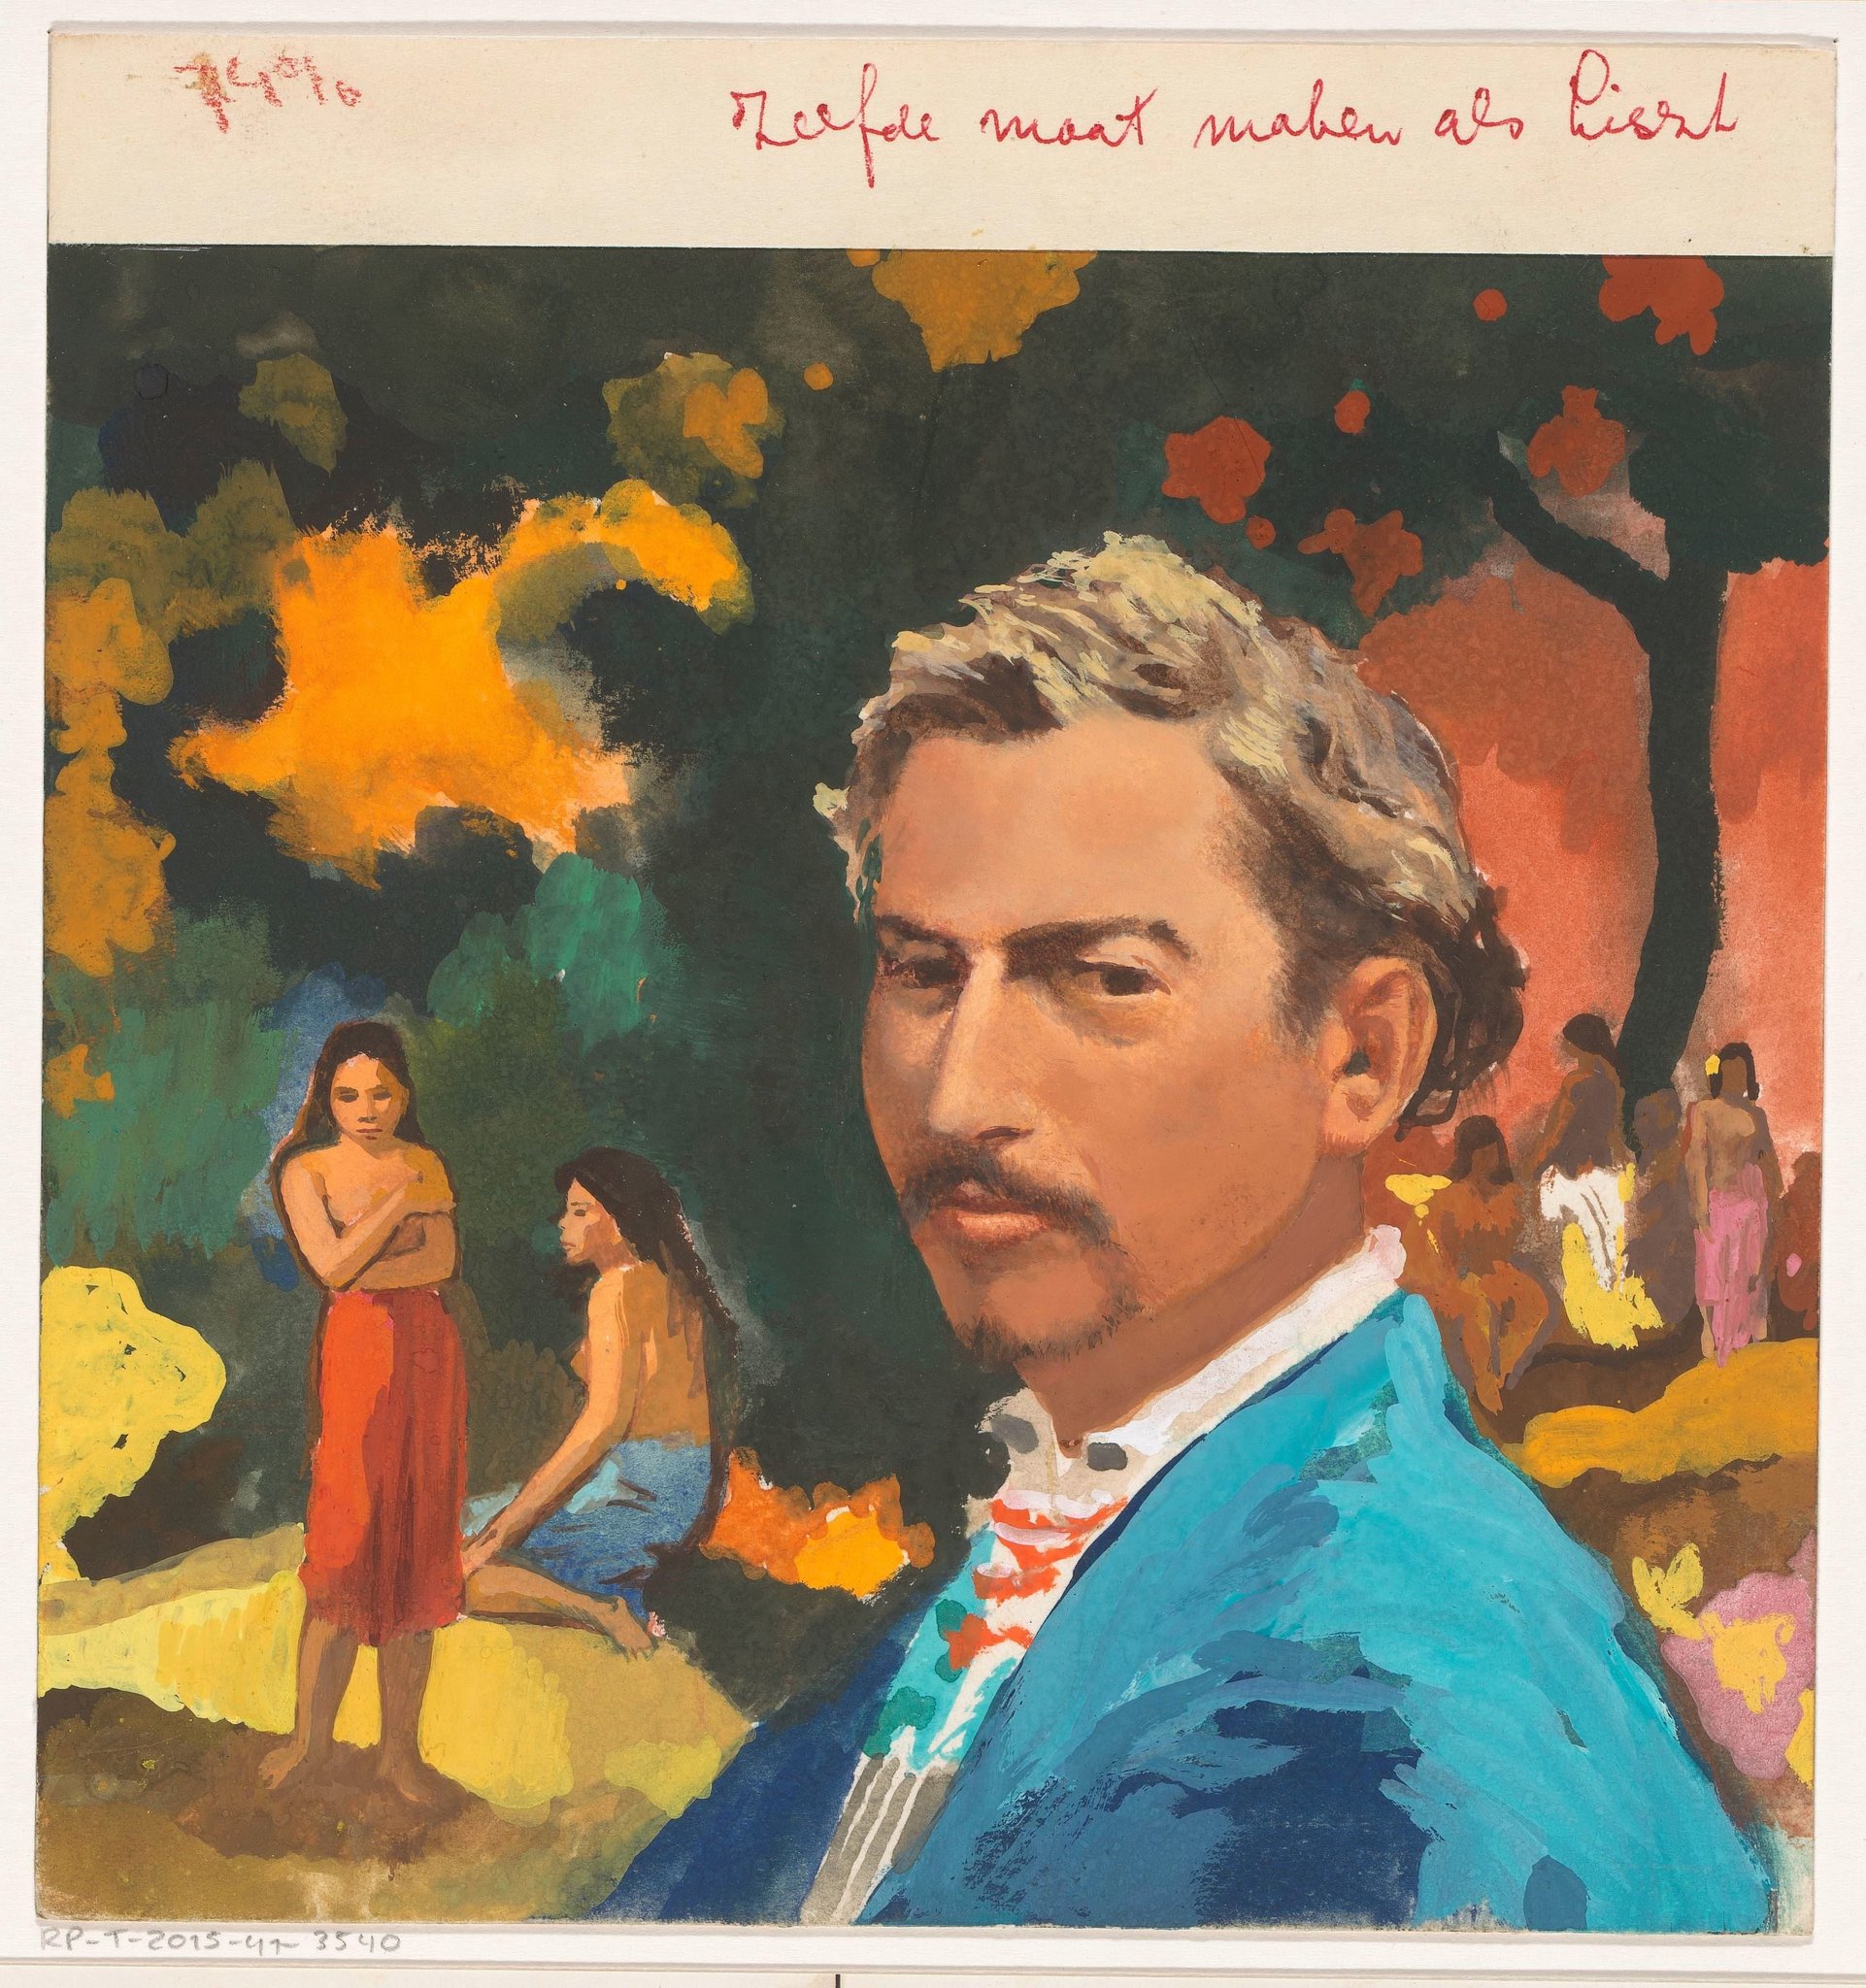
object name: drawing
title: Bandontwerp voor: Claude Francolin, Paul Gauguin. Het leven van een groot schilder, c. 1958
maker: Anonymous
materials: paint, paper, pencil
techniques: brush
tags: paris, print maker, paul gauguin, landscapes in the non-temperate zone, exotic landscapes, portrait, self-portrait of artist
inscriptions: clichéaanwijzing, recto, handgeschreven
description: Portret van de schilder Paul Gauguin met in de achtergrond één van zijn schilderijen van jonge vrouwen in een Tahitiaans landschap.